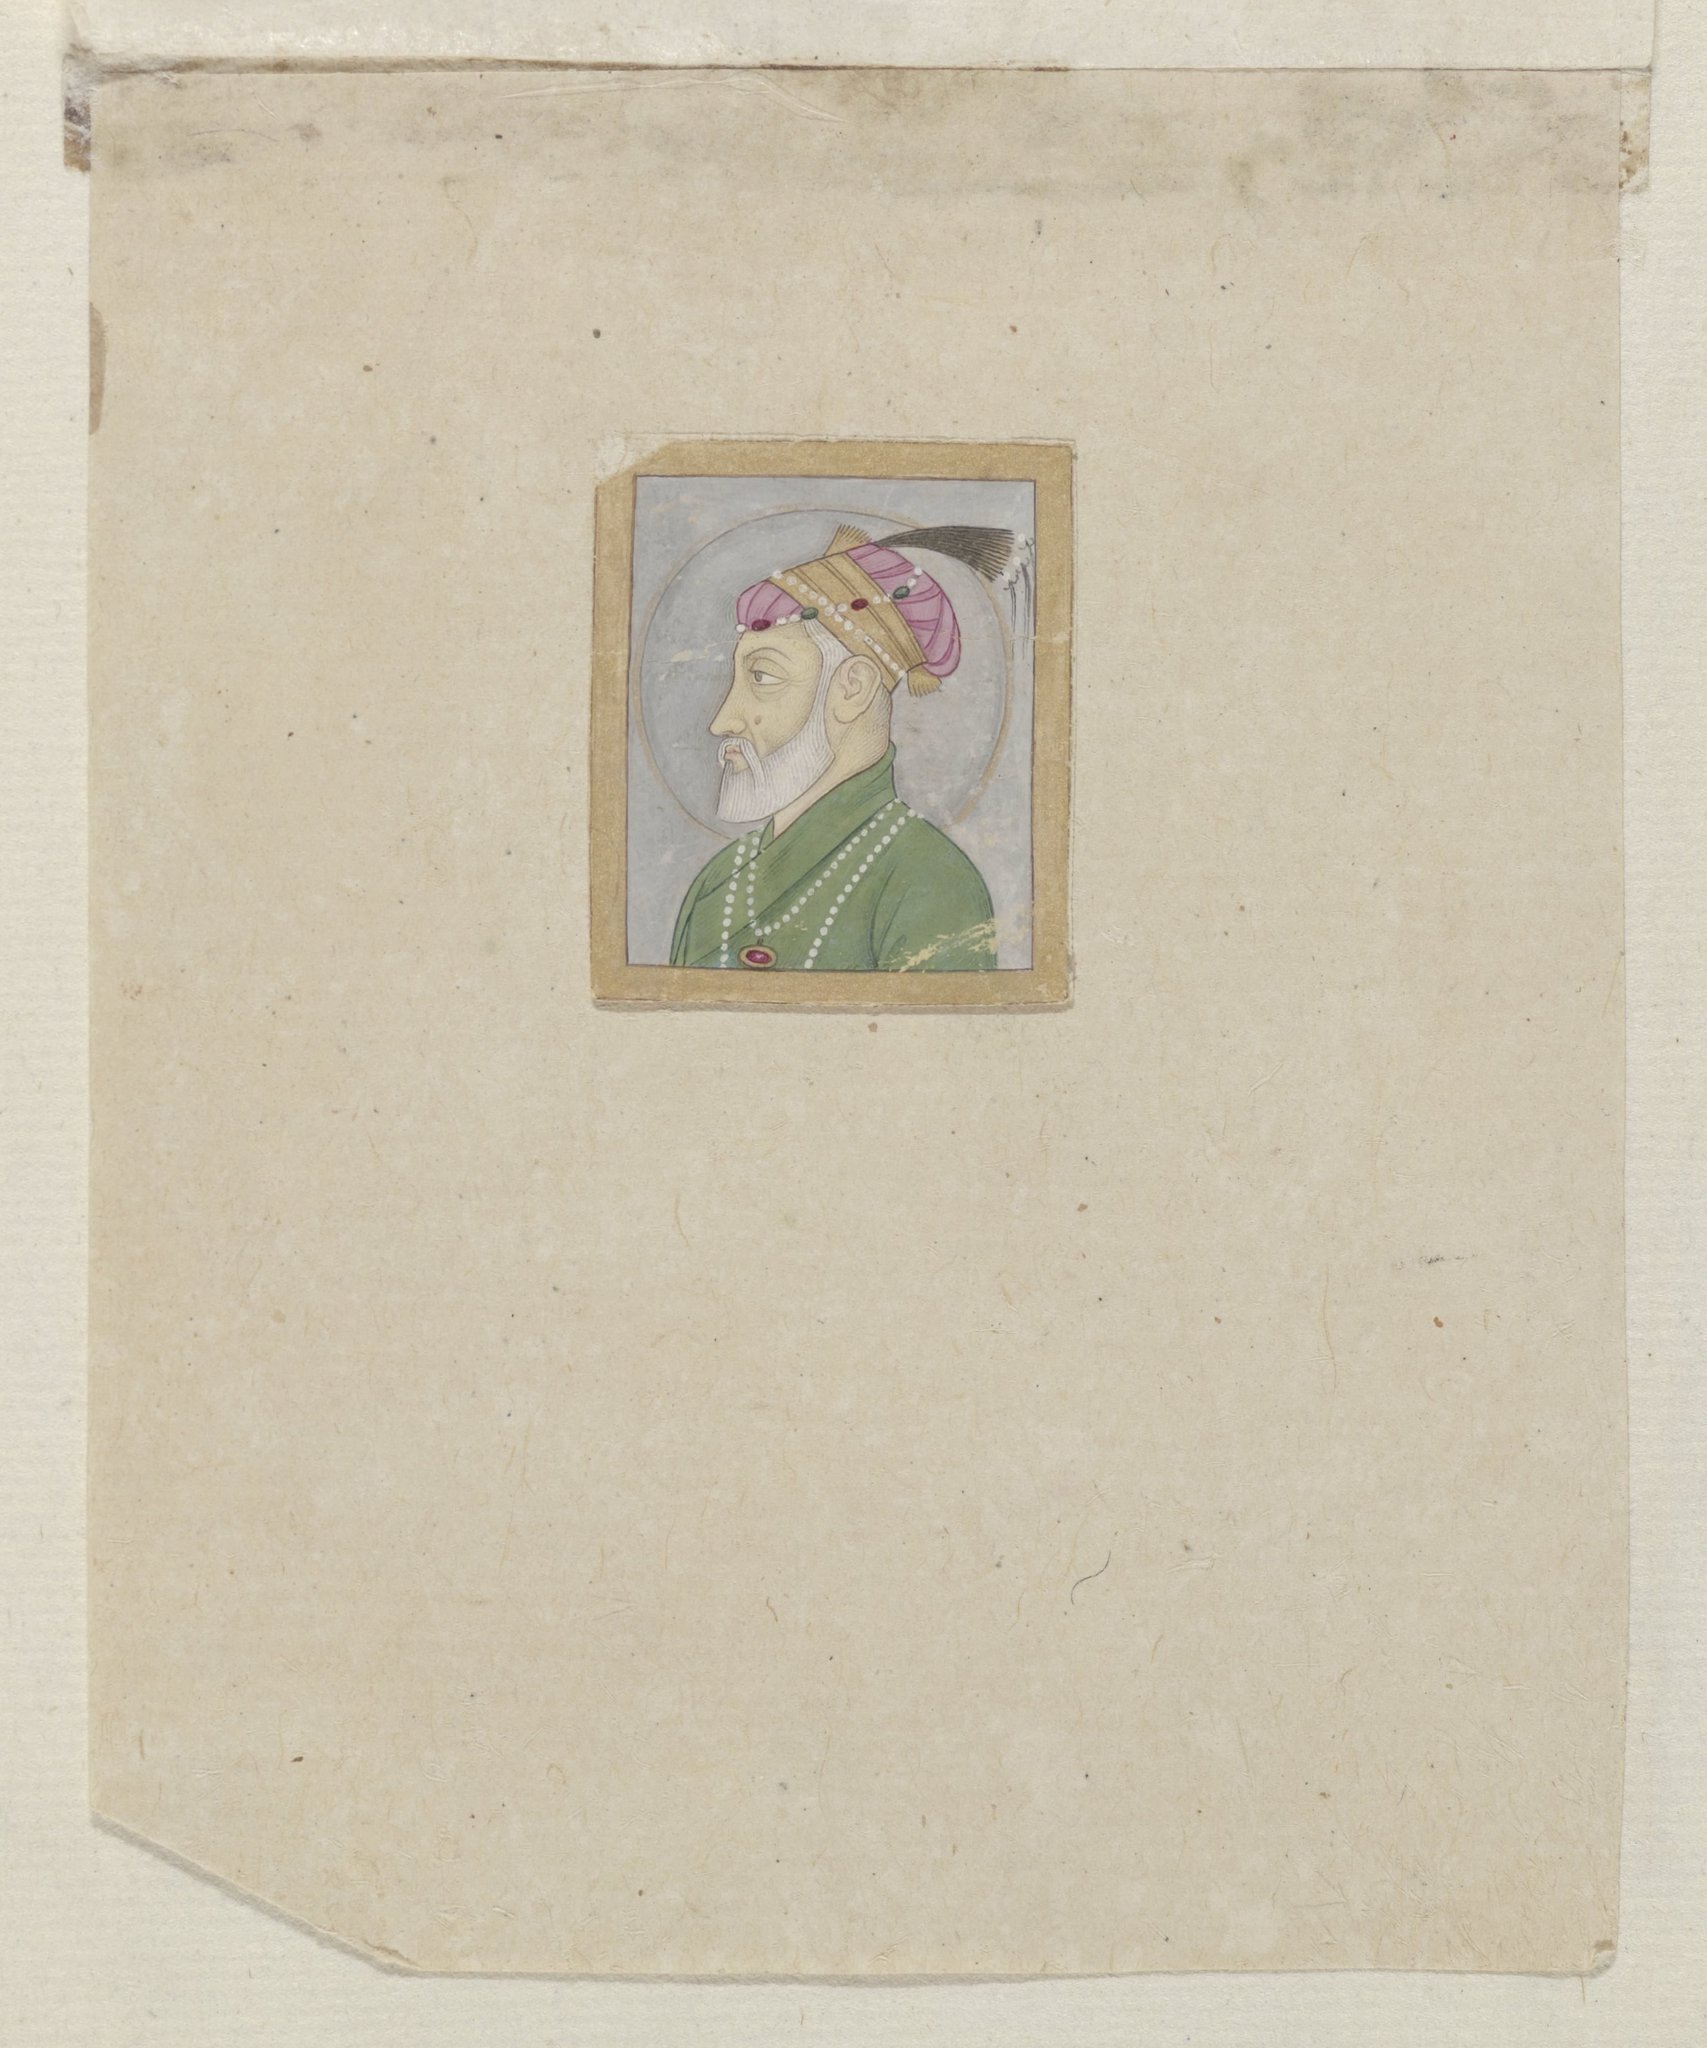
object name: drawing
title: Hoemojoen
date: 1675-1725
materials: paper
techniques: drawing, writing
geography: deccan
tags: adrianus canter visscher, historical persons, ruler, sovereign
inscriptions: caption: ‘Hoemojoen soon van Baber sevende koning of mogol / van Indostan syn levensdraad is afgesneden ao 1552’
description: Tekening uit het manuscript van de VOC dienaar Adrianus Canter Visscher met achterin achtentwintig Indiase miniaturen en twee kaarten van plaatsen aan de Coromandelkust. De tekst bestaat uit twee delen: een geschiedenis van het Mogolrijk en de VOC-vestigingen aan de Coromandelkust; daarna volgt een advies aan de Heren XVII over de economische situatie van de VOC in de Coromandel.